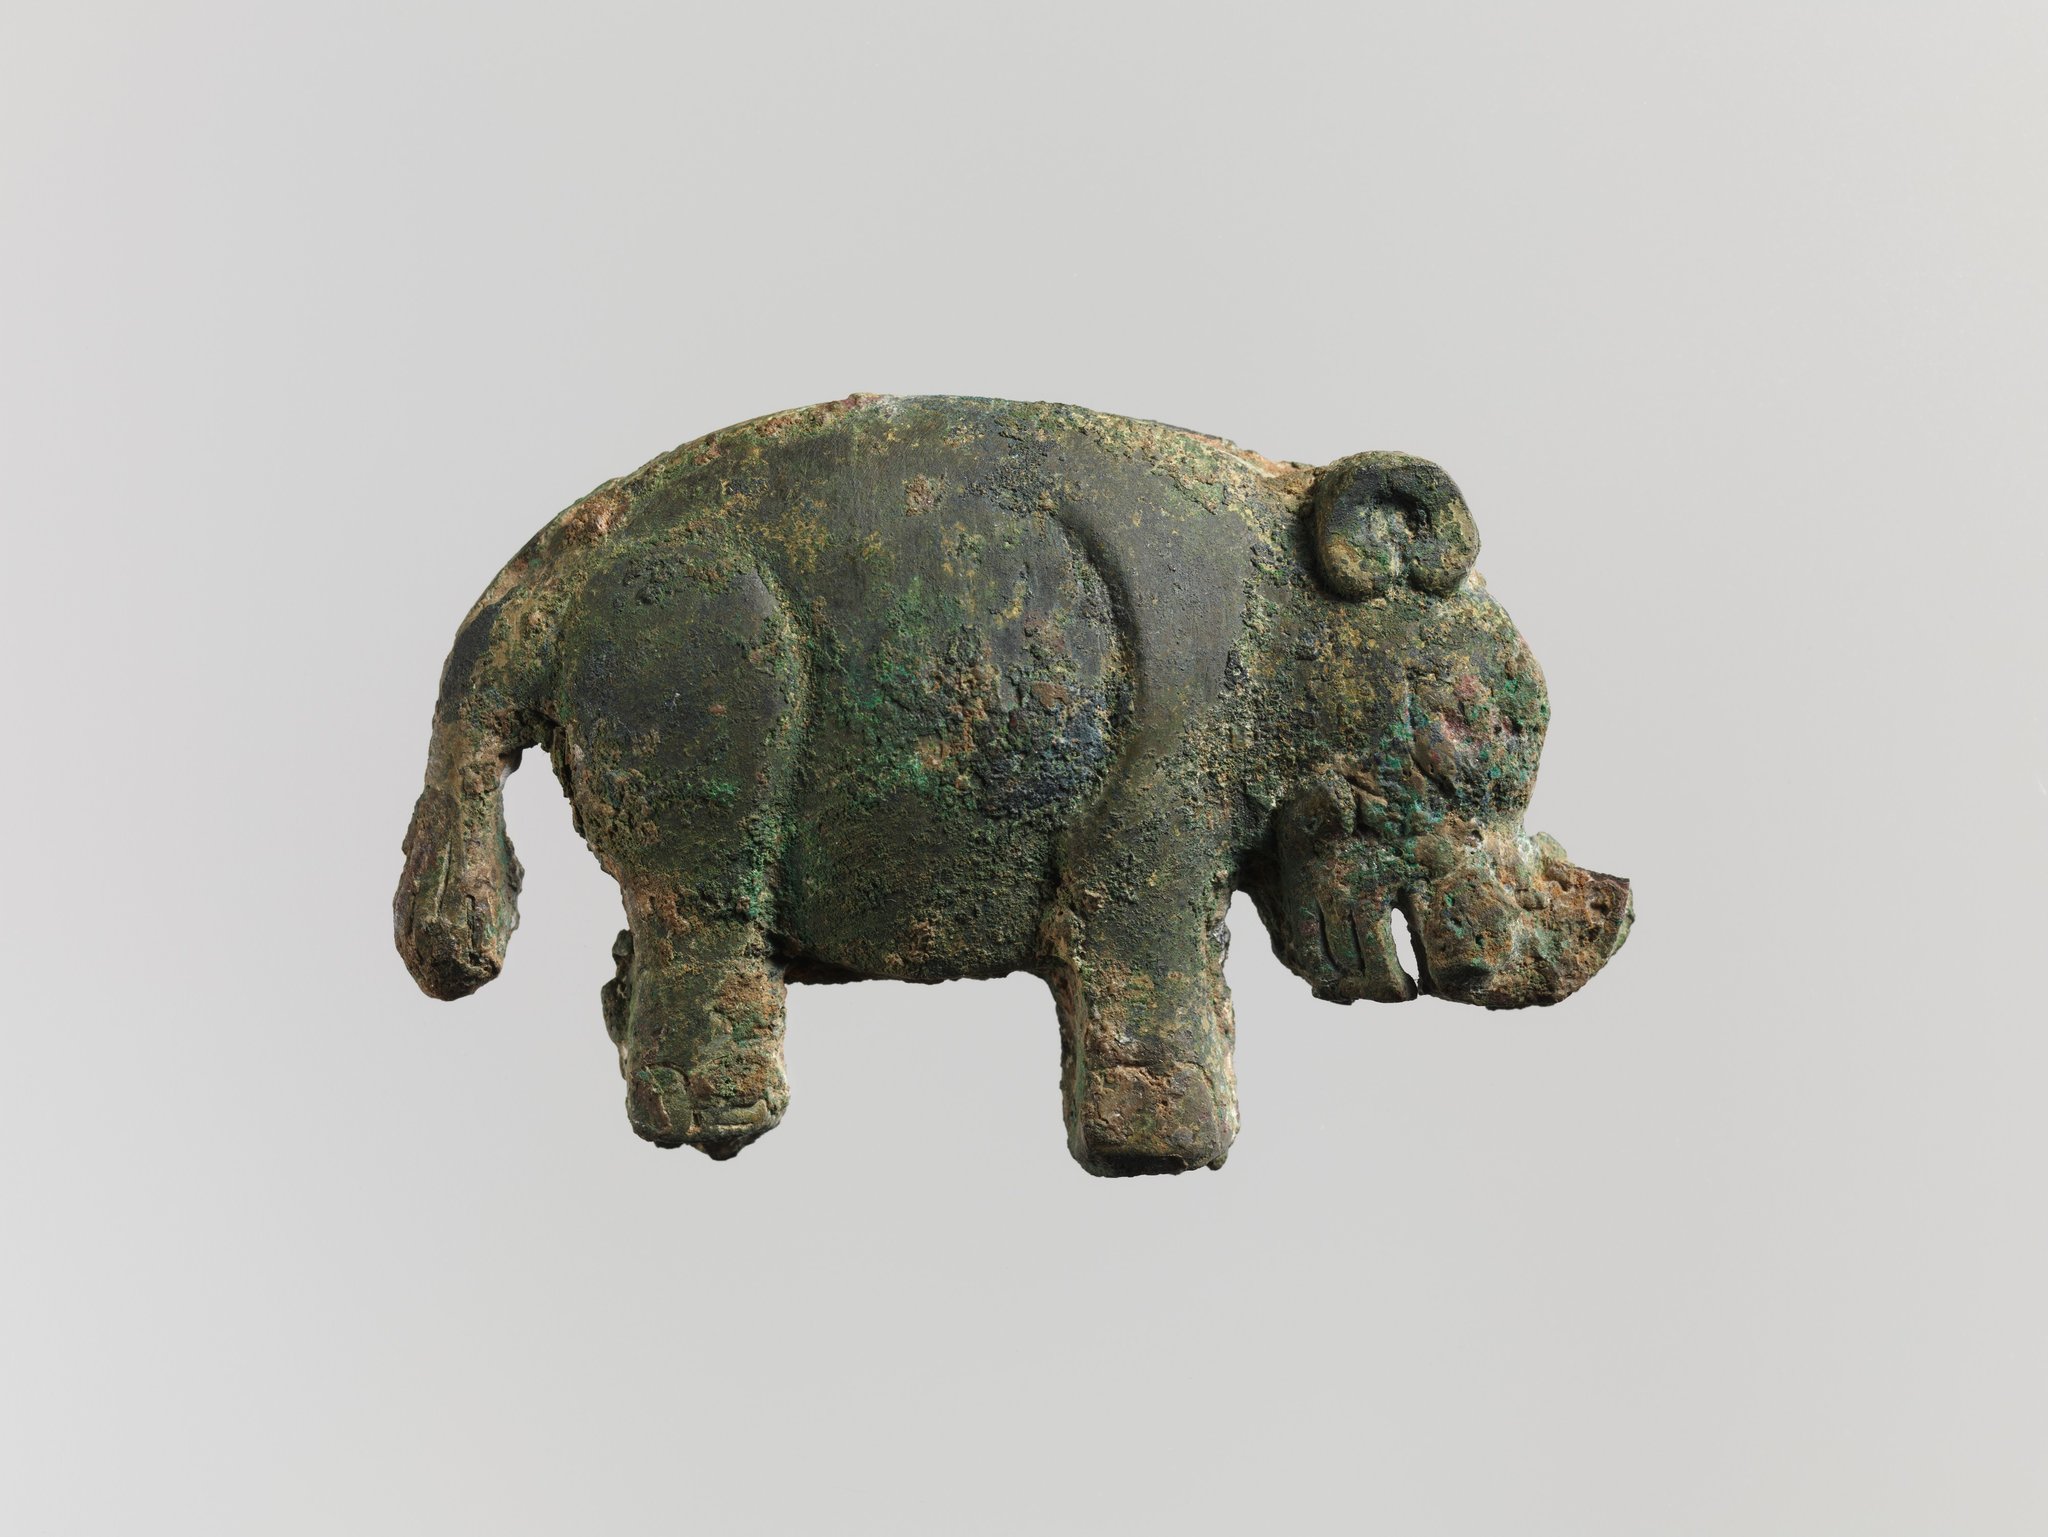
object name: figure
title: Elephant Relief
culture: chinese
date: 1600-1046 BCE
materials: bronze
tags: elephants